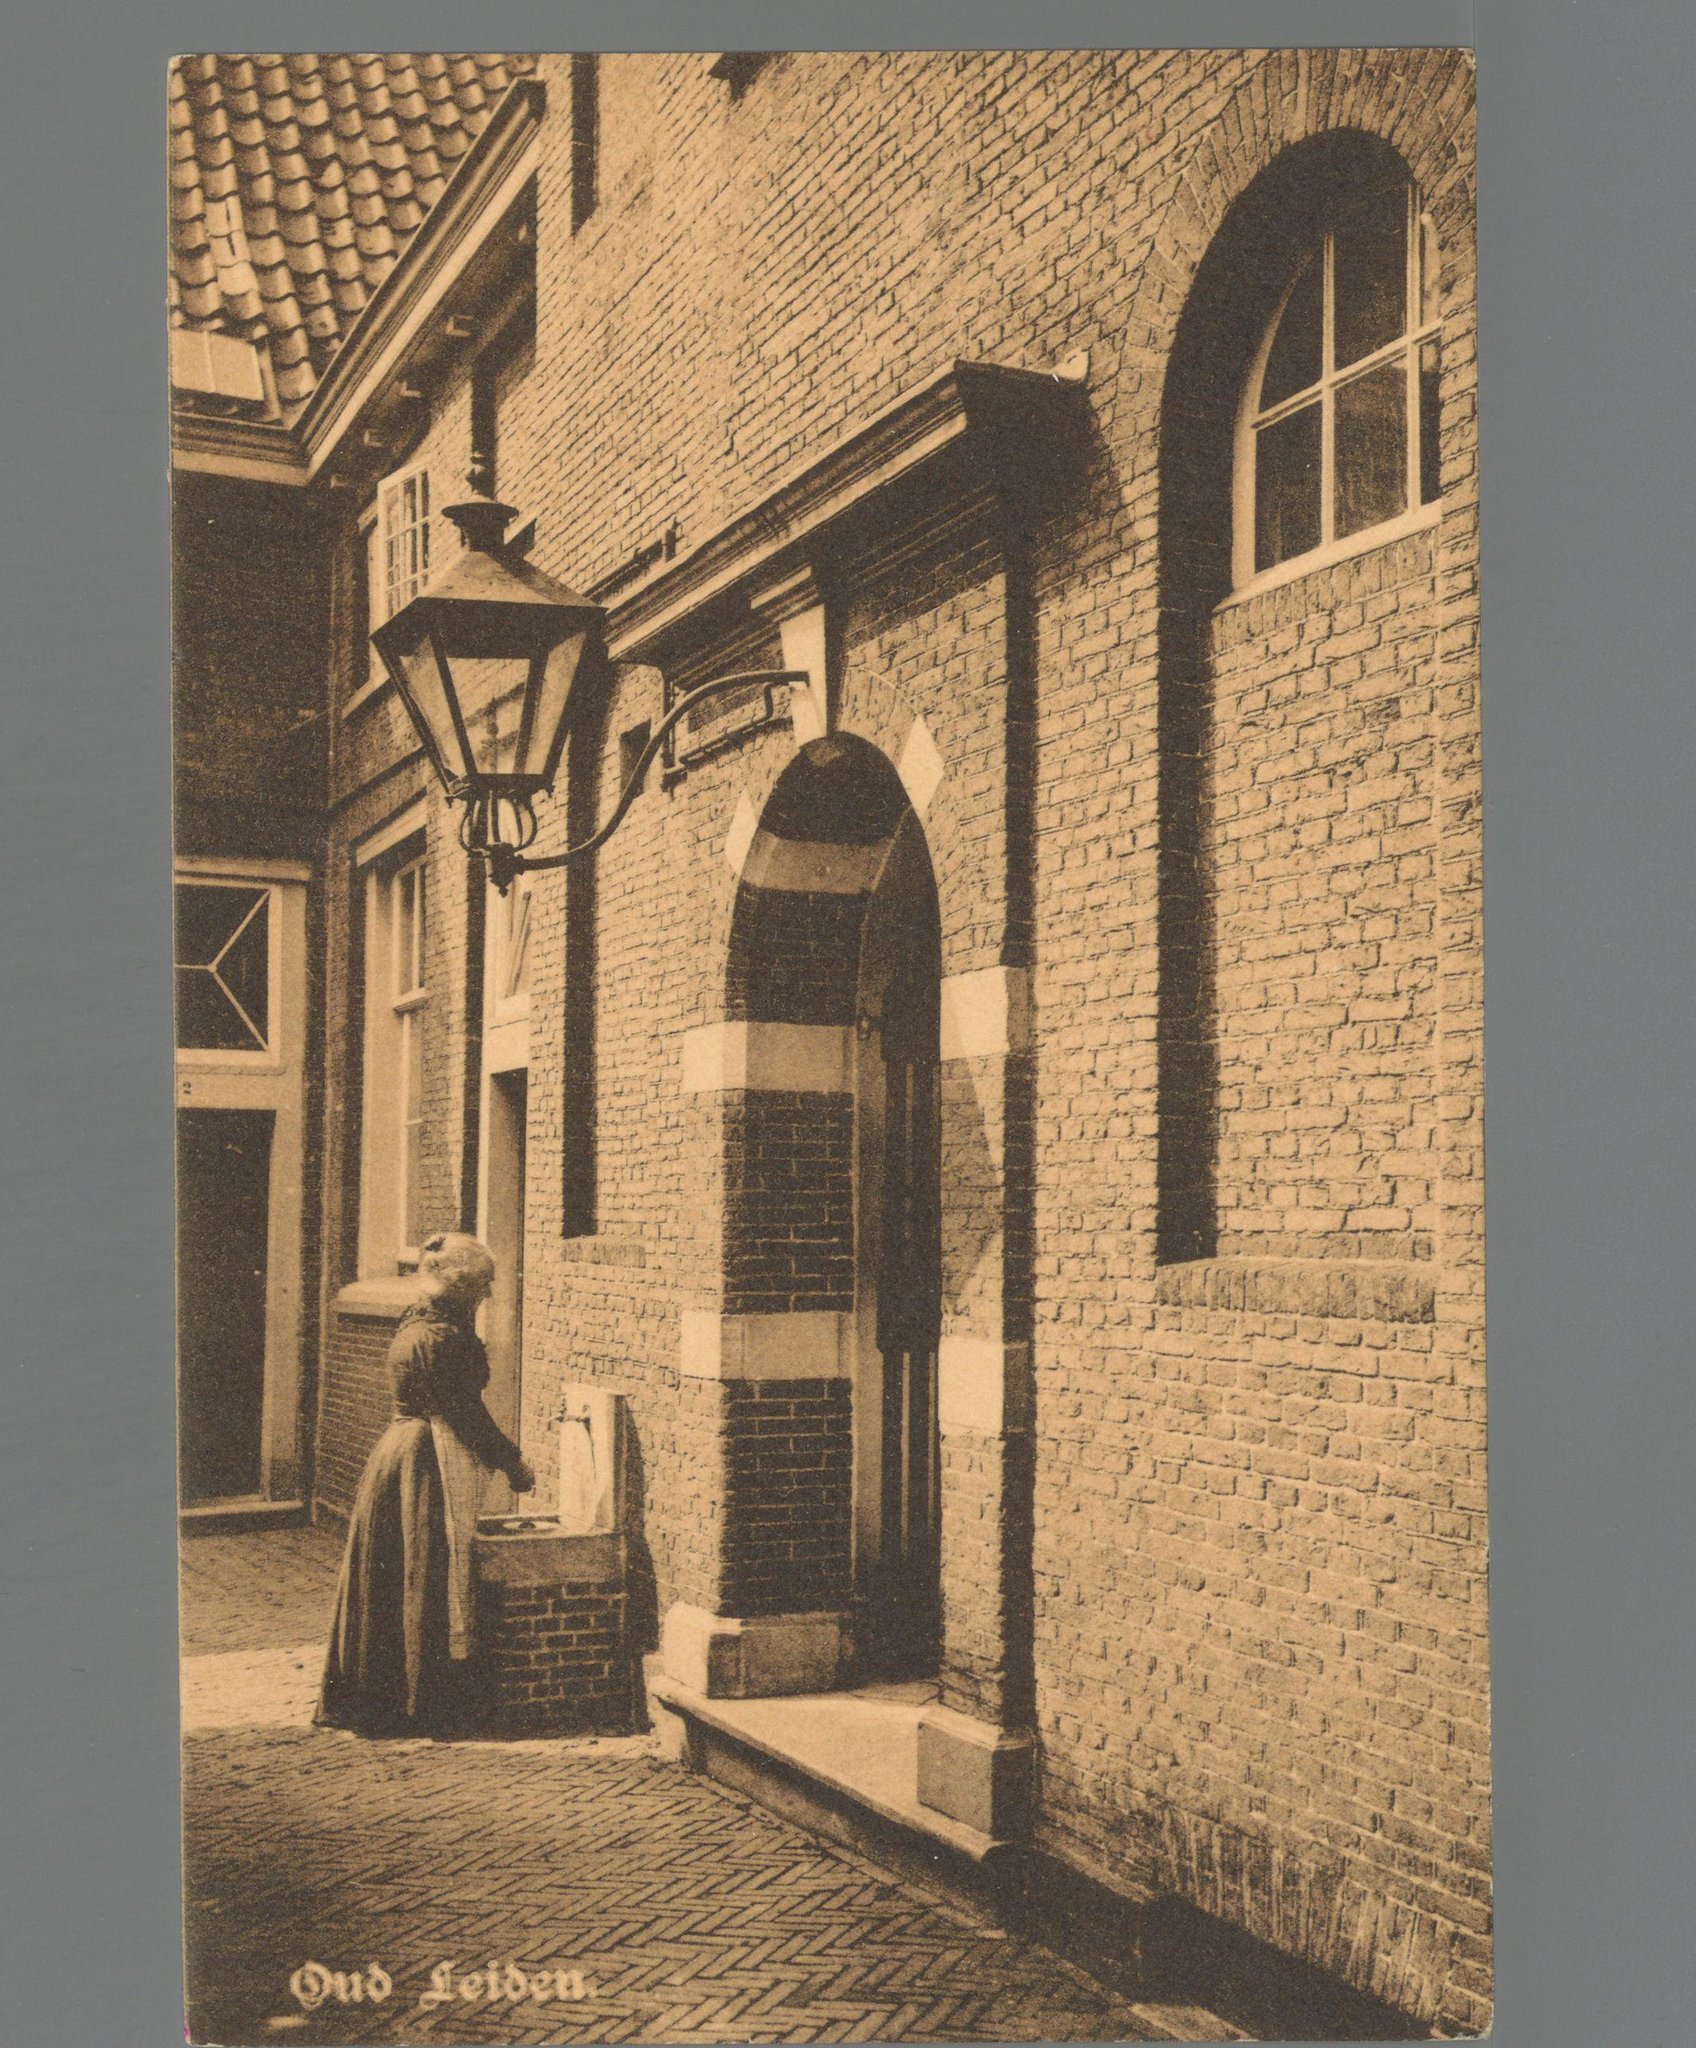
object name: ansichtkaart, prentbriefkaart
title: Jan Persynshofje. Hier woonde Rev. John Robison. M.A. of the Pelgrim Fathers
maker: Anonymous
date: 1905-1930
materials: cardboard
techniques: photograph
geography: leiden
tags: alms-house (dutch: 'hofje'), gate, entrance